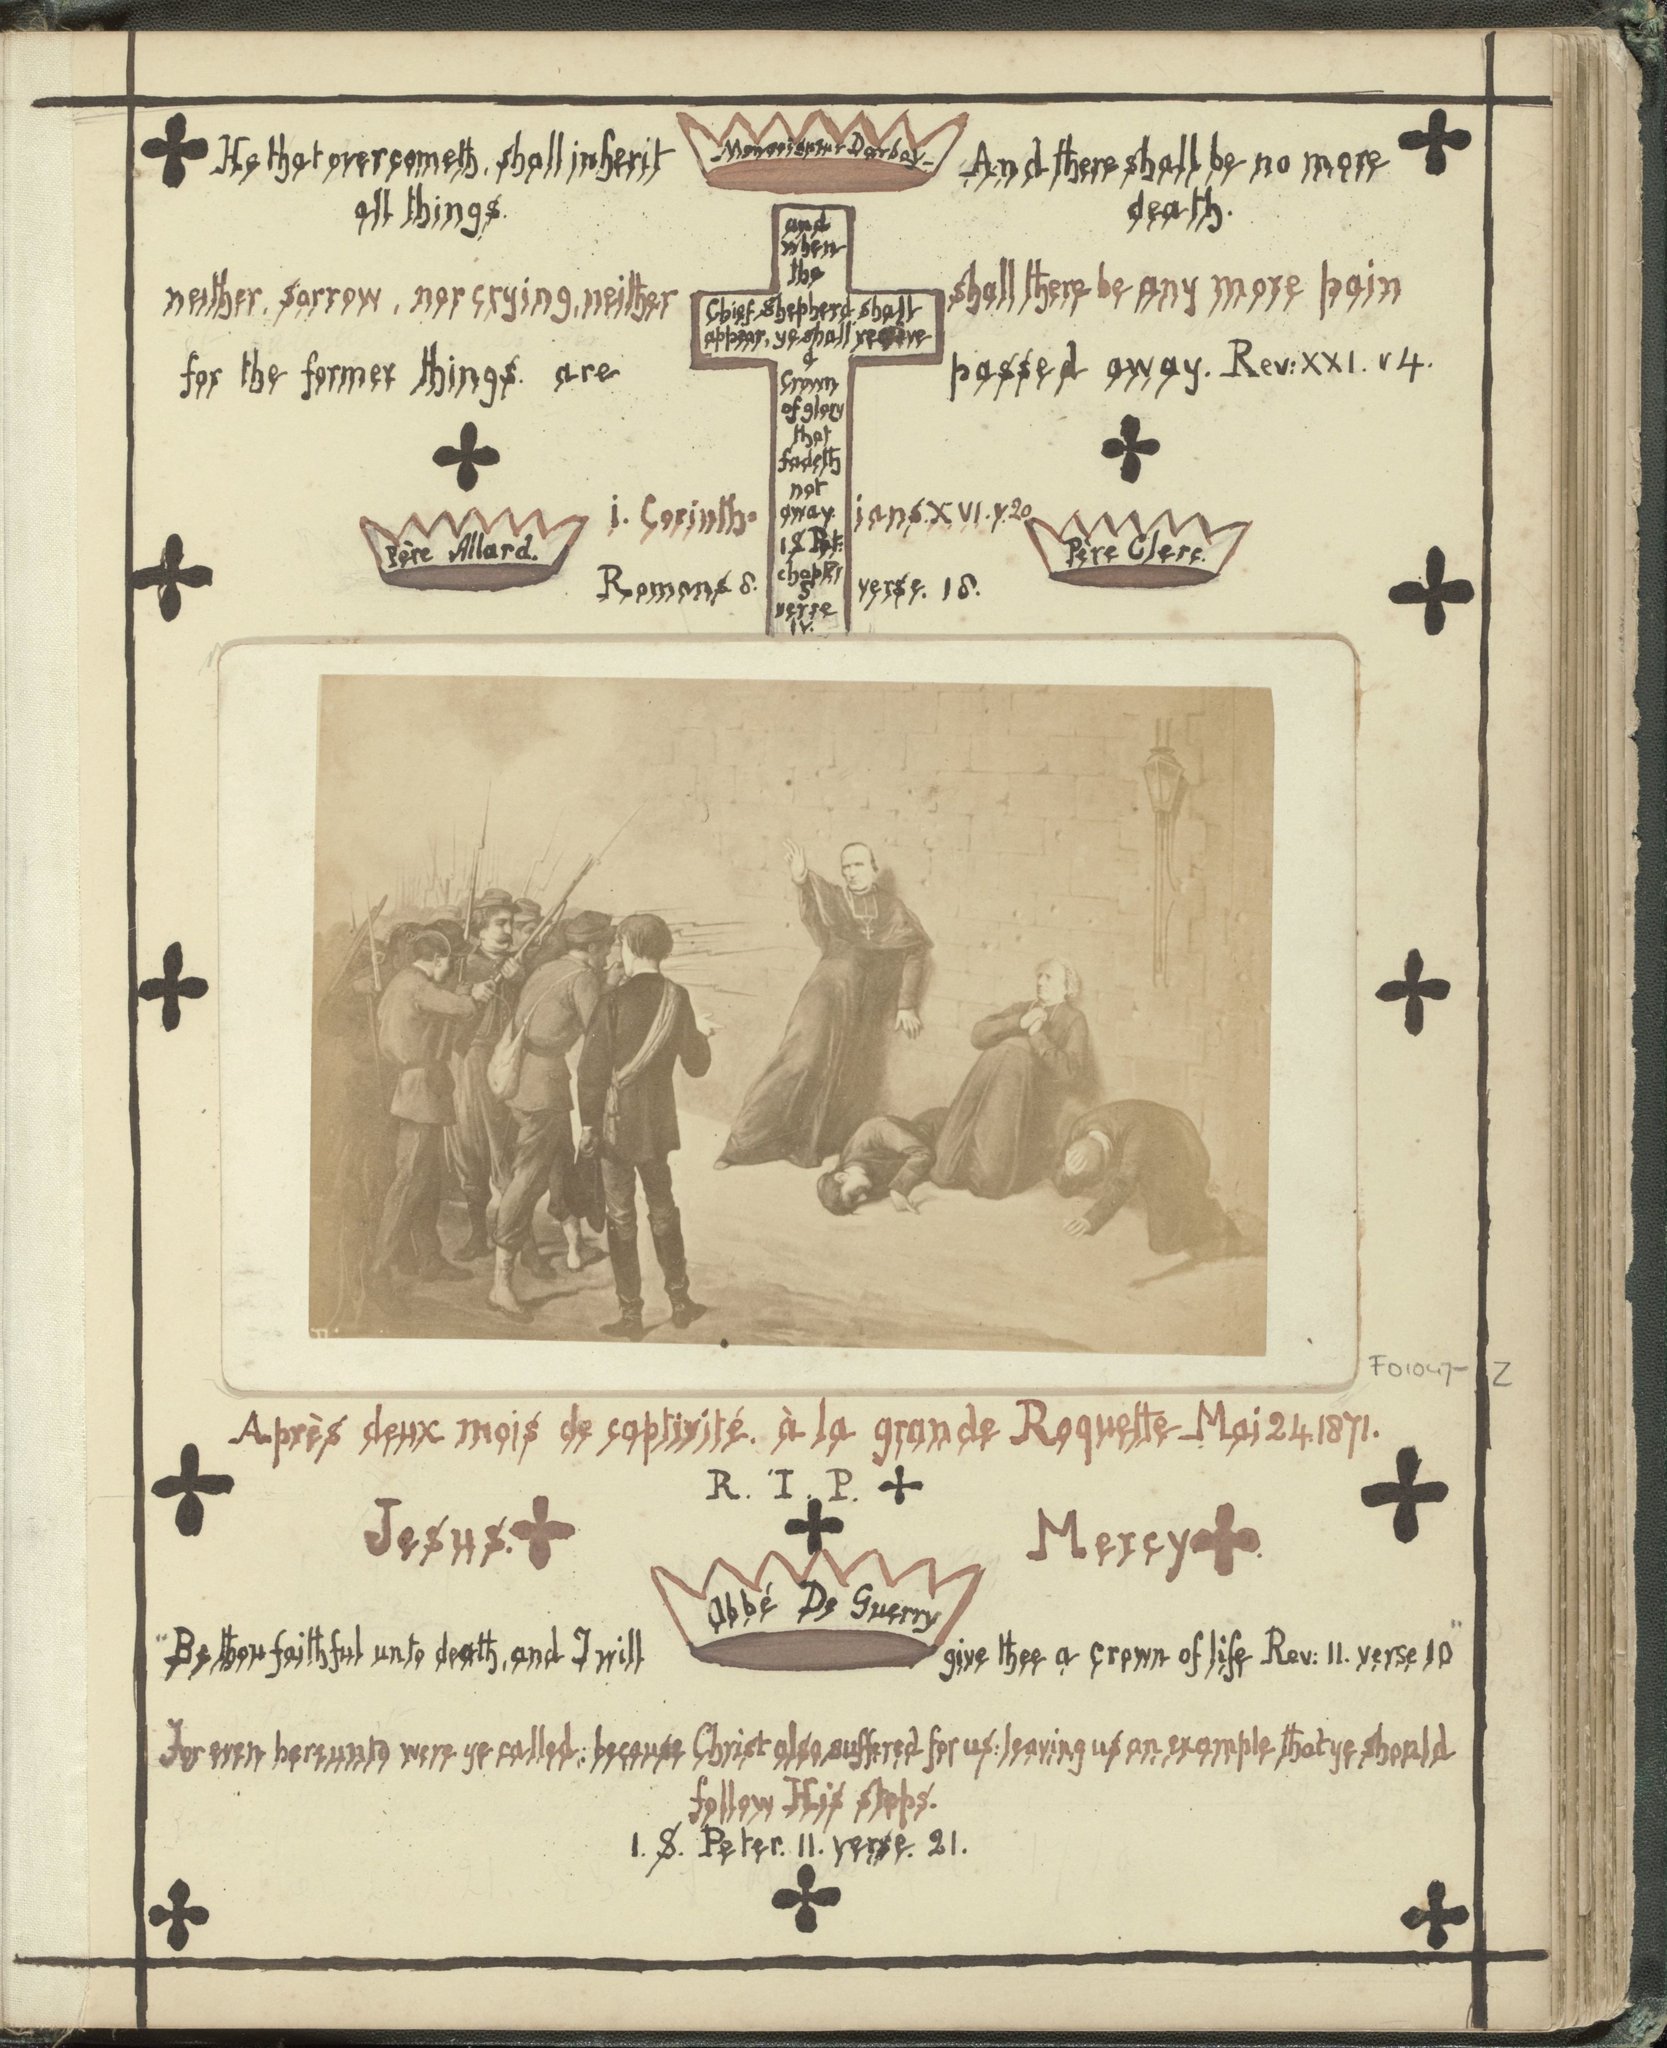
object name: album leaf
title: Reproductie van (vermoedelijk) een tekening van de fusillade van vier geestelijken in de Parijse gevangenis la grande Roquette, omgeven door Engelse en Franse tekst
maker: Anonymous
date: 1871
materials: cardboard, paper, photographic support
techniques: albumen print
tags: priest (roman catholic), death penalty, execution, paris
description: Onderdeel van Herdenkingsalbum van rooms-katholieke geestelijken gevallen tijdens de Commune van Parijs.